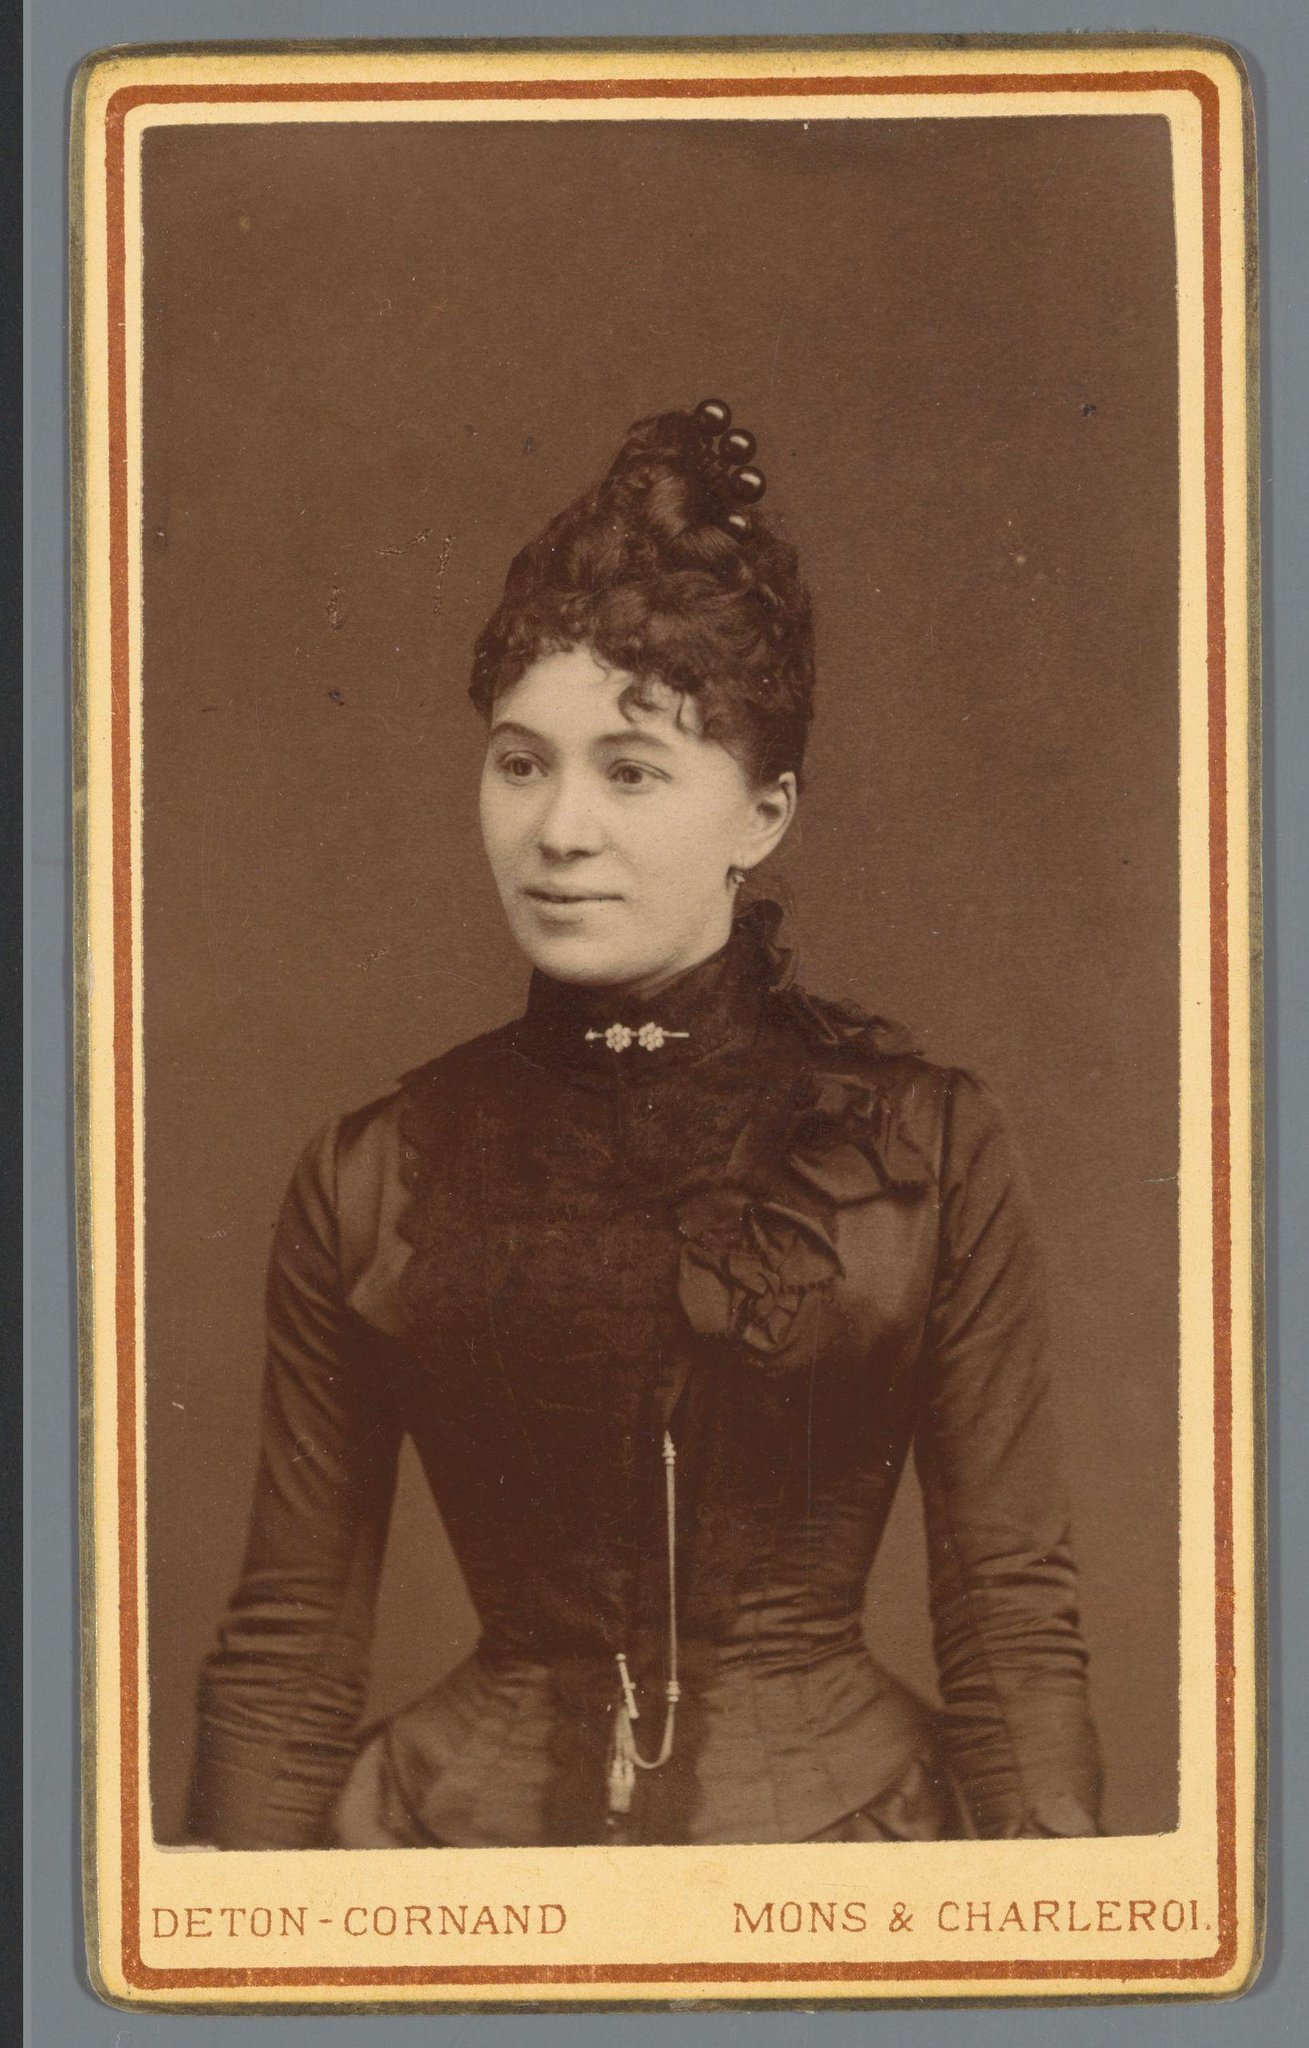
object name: photograph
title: Portret van een onbekende jonge vrouw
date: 1896-1900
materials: cardboard, paper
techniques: albumen print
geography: charleroi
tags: adolescent, young woman, maiden, anonymous historical person portrayed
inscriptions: inscription: ‘Deton-Cornand Mons & Charleroi.’, inscription: ‘Deton-Cornand/ 42, Rue de la Montagne, 42/ Charleroi/ et/ 22, Grand'Rue 22,/ Mons./ 12. Portraits, 6 Frcs. 50 cs./ Grands portraits et reproductions./ Les clichés sont conservés.’